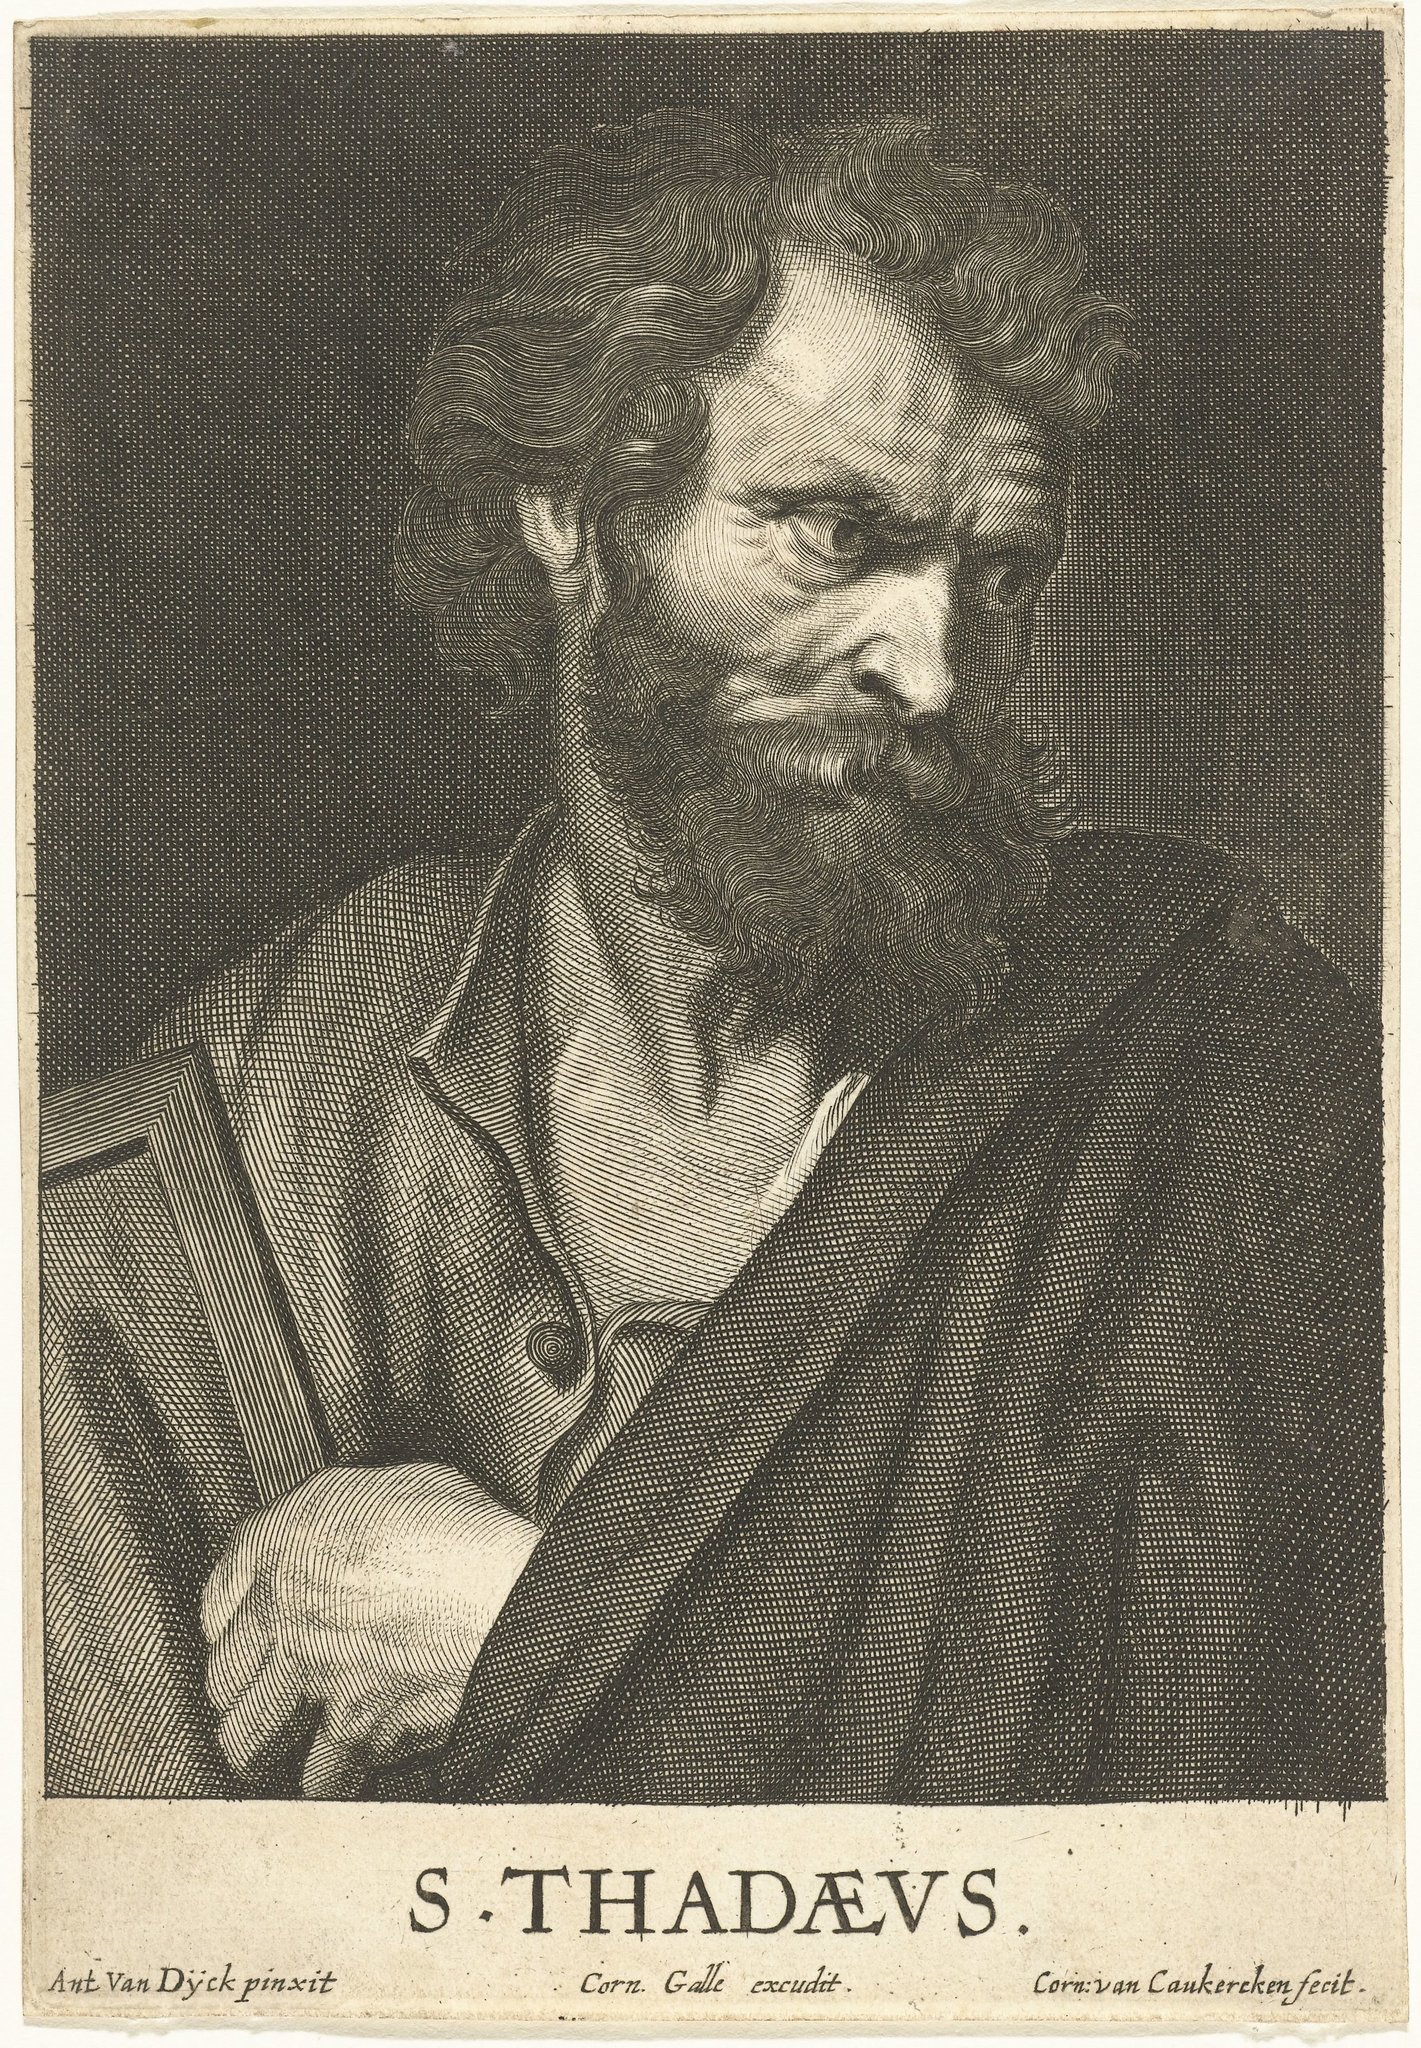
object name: print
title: Christus en de apostelen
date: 1640-1680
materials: paper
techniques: engraving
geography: antwerp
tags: the apostle jude thaddaeus; possible attributes: book, club, halberd, scroll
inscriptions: collector's mark: Lugt 2228